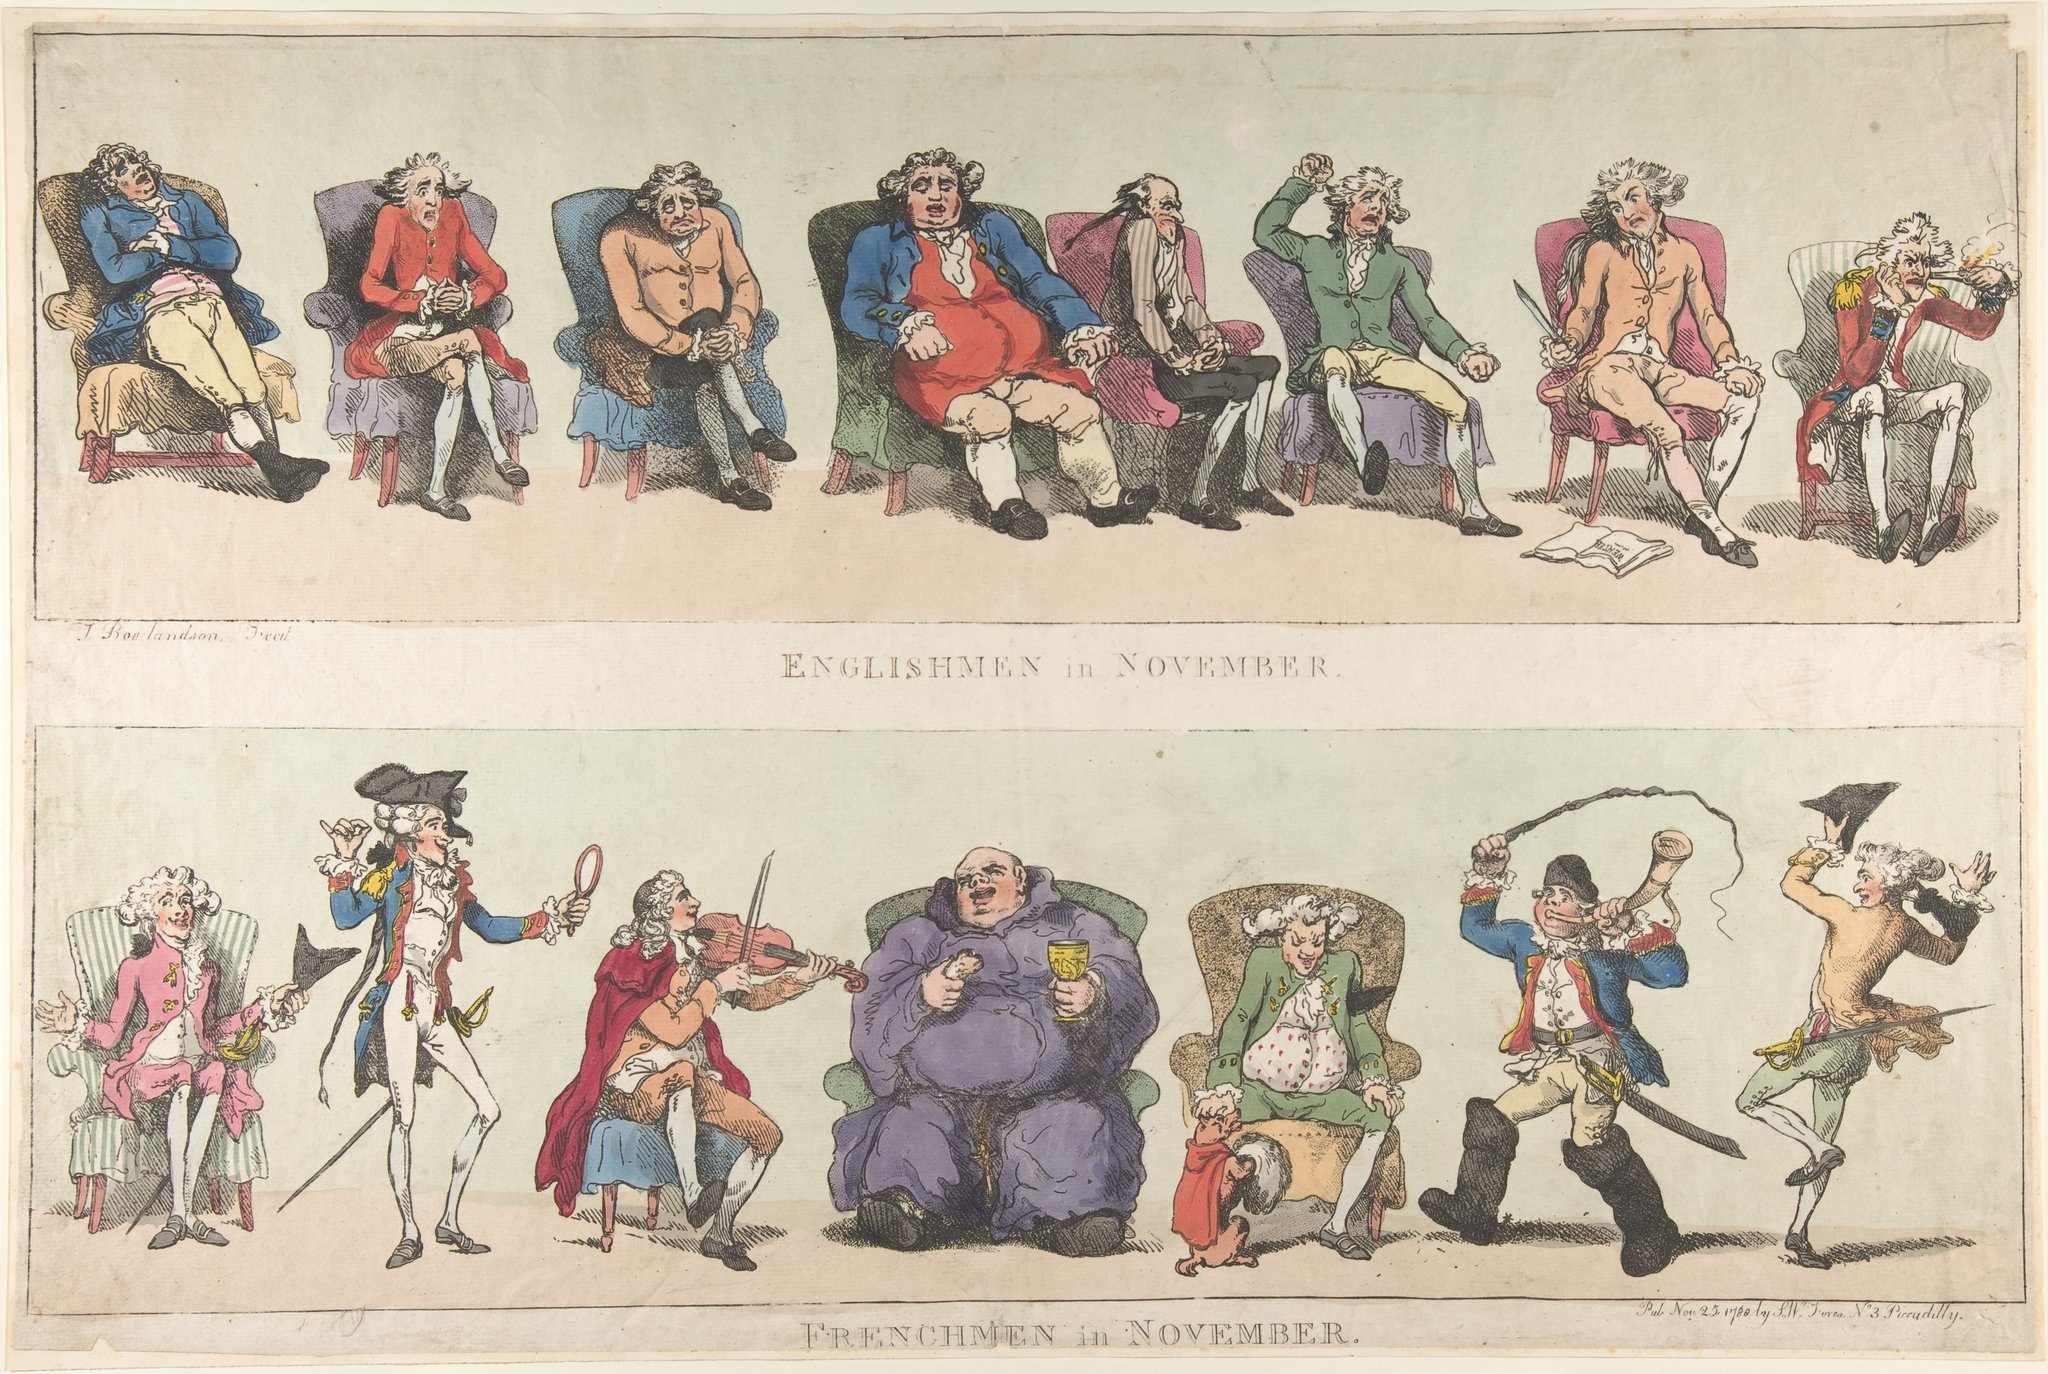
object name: print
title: Englishmen in November, Frenchmen in November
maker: thomas rowlandson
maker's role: artist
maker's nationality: british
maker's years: 1757-1827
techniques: etching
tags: men,women,violins